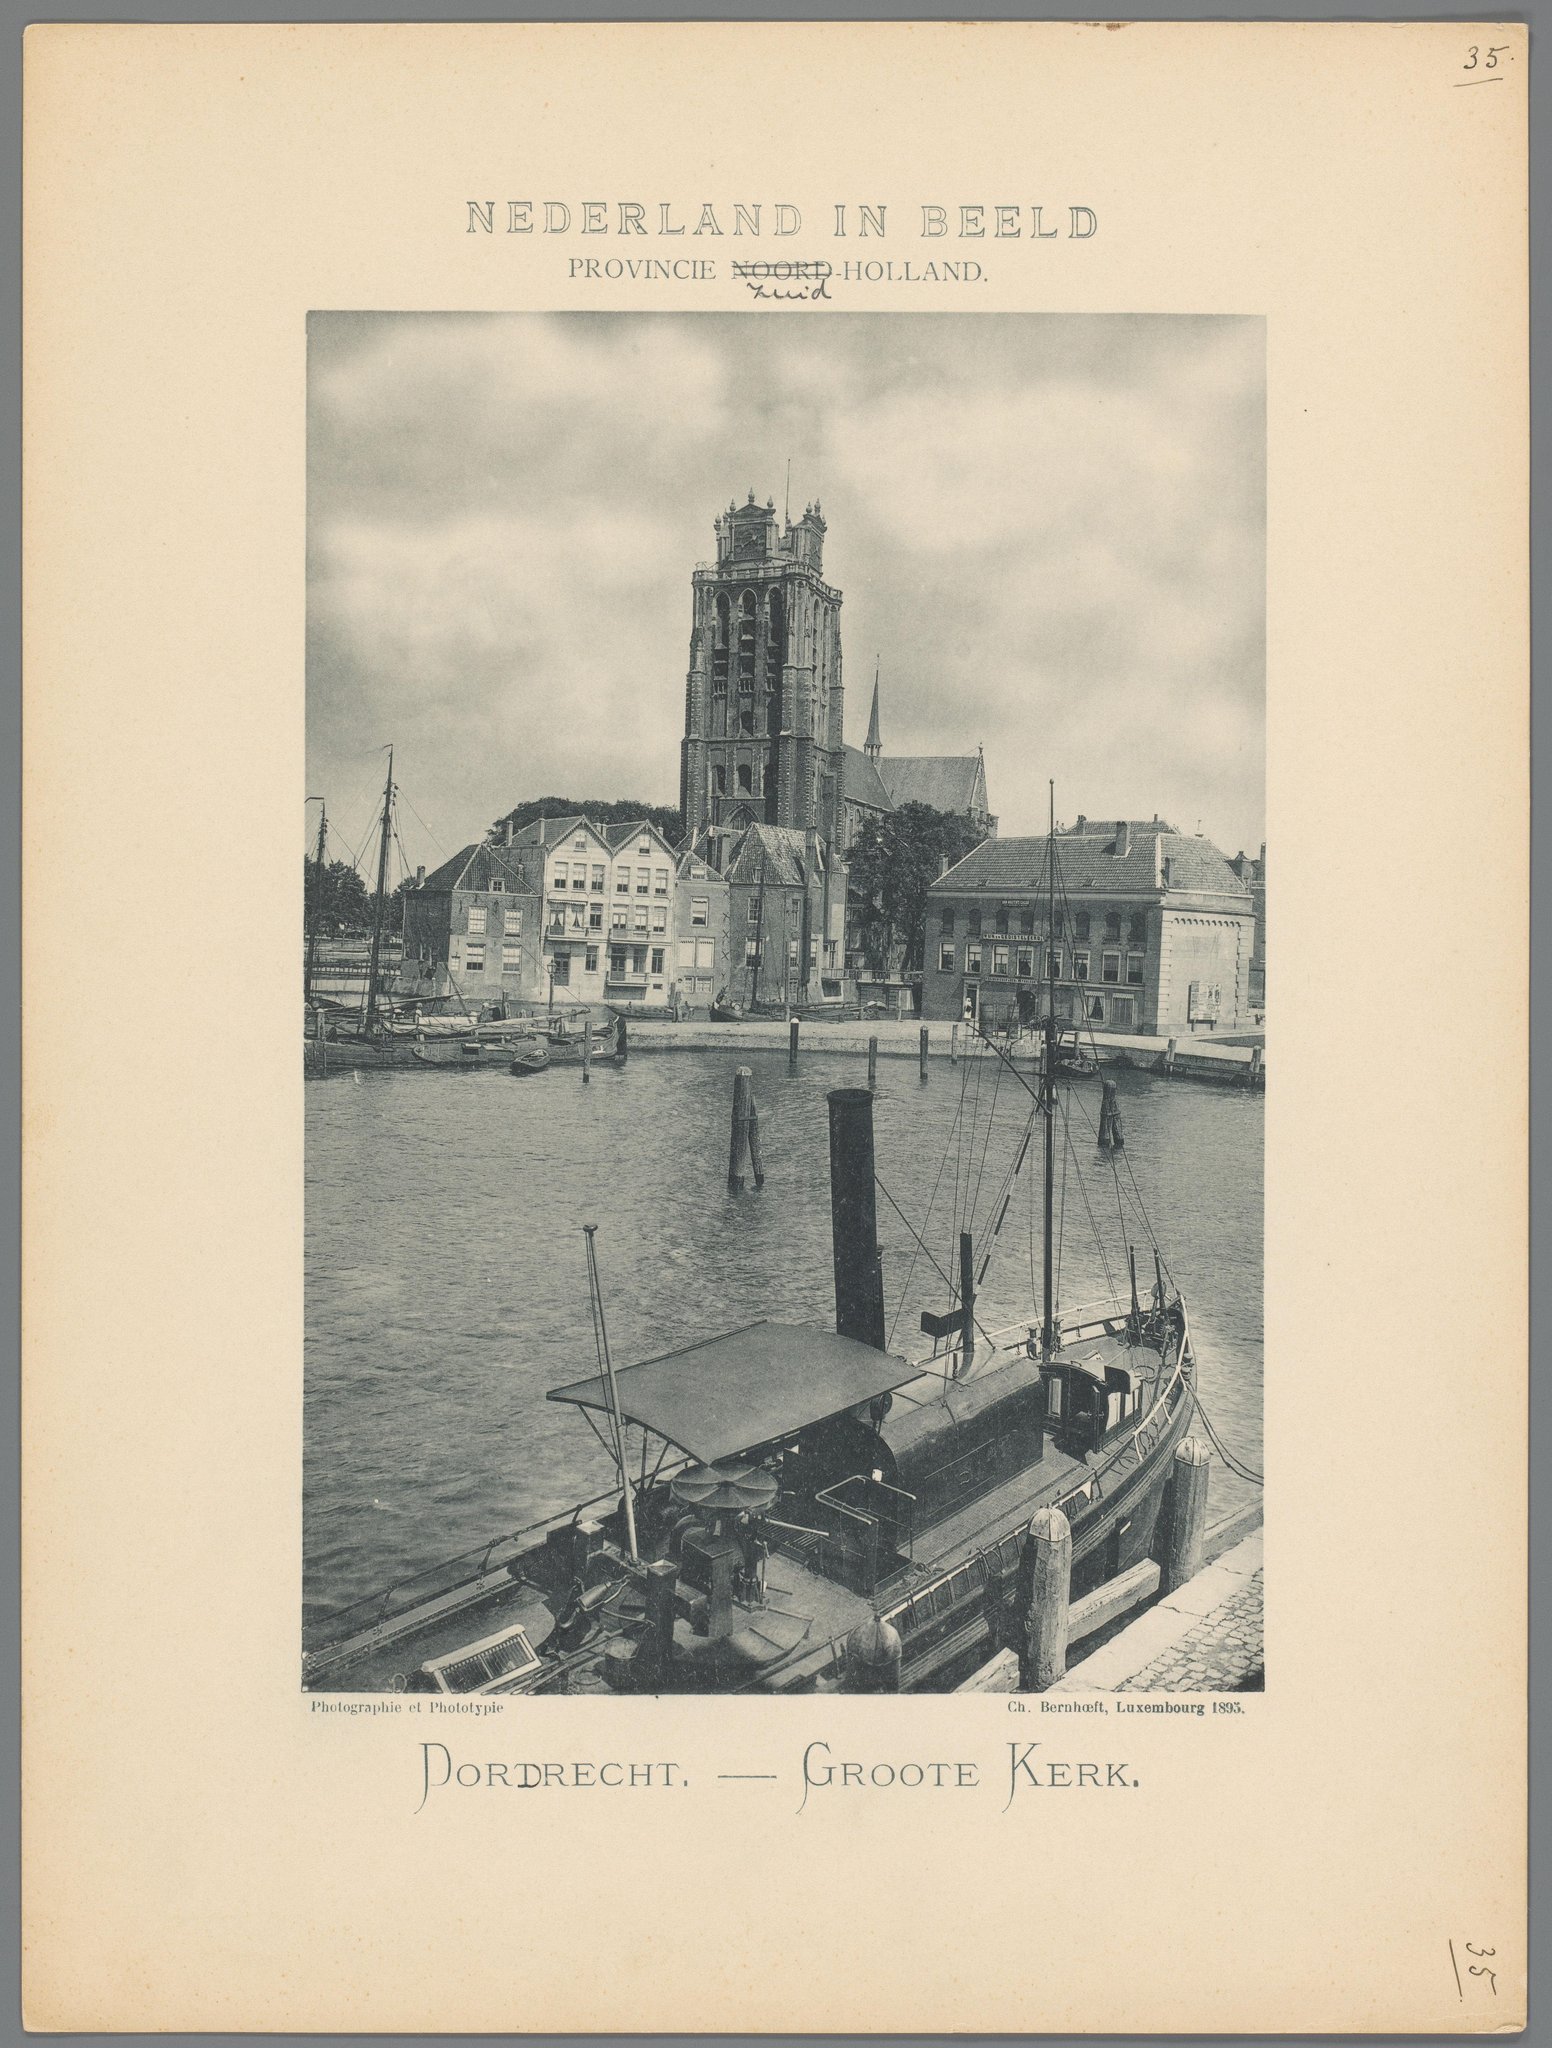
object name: photomechanical print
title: Gezicht op de Grote Kerk te Dordrecht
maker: charles bernhoeft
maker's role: publisher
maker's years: 1859-1933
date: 1895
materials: paper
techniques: photograph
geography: dordrecht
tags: harbour, church (exterior)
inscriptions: number: ‘35.’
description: Deze prent maakt deel uit van een omslag met 43 lichtdrukken op 43 bladen.